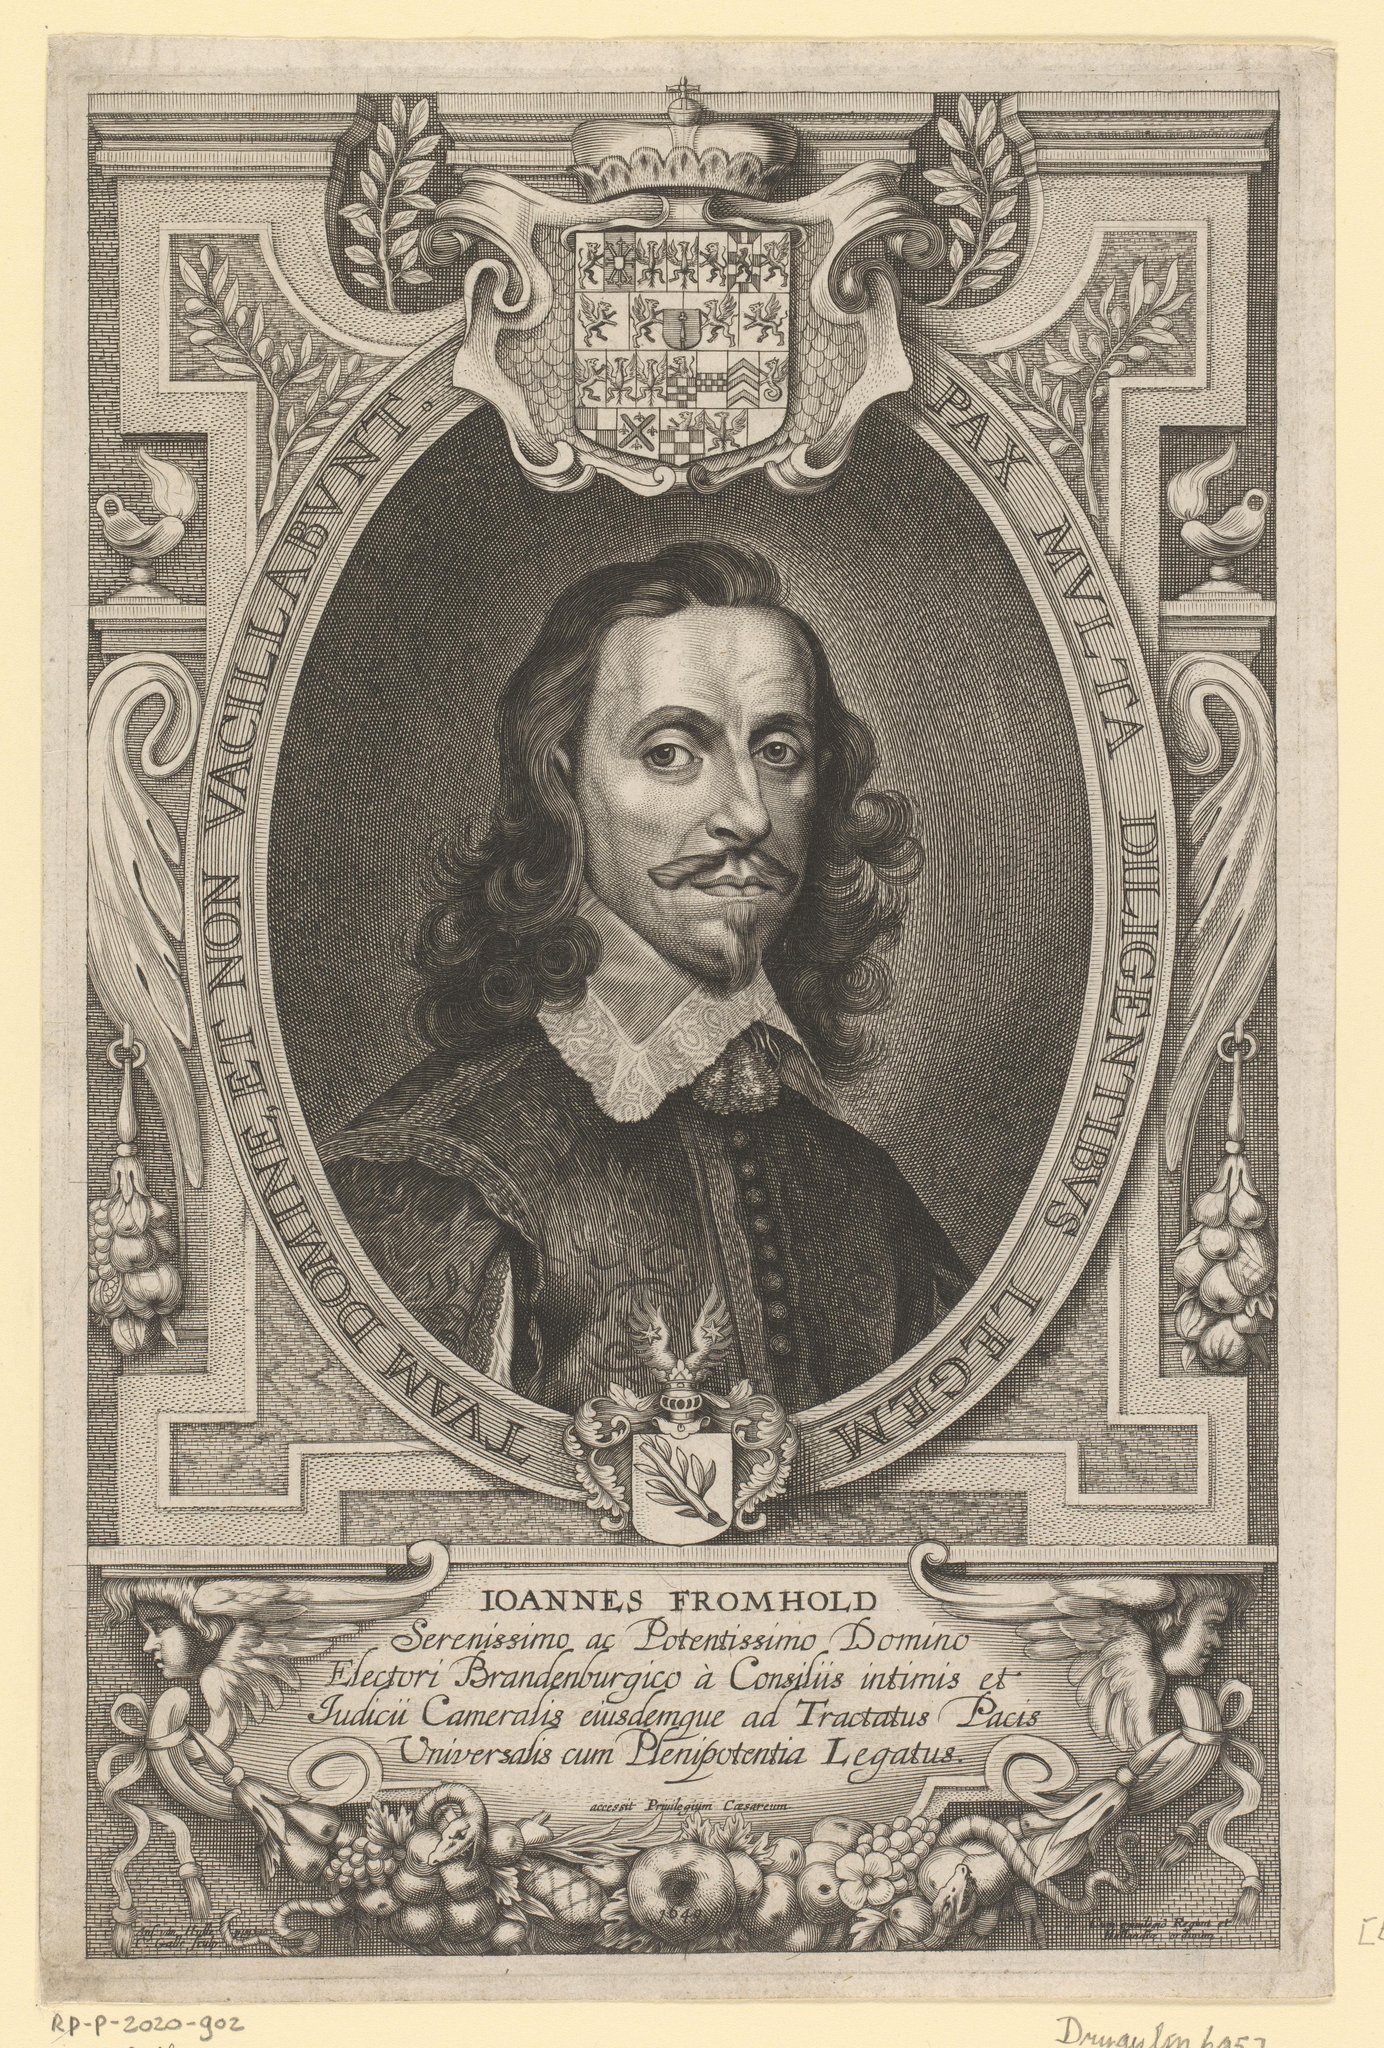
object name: print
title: Portret van Johann Fromhold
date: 1649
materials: paper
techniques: engraving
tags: official; civil servant; functionary (in general), historical persons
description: Prent is gebruikt in verschillende series. De huidige staat is gebruikt in de hieronder vermelde serie en uitgaven (3) en (4) en mogelijk ook in (5) en (6). (1)'Icones legatorum (...)', uitgegeven door Daniel Middeler in 1648 in Antwerpen. (2)‘Legati Celeberrimi’, uitgegeven door Daniel Middeler in 1648 in Antwerpen. (3)‘Legati Celeberrimi’, waarschijnlijk uitgegeven in 1651, maar opnieuw met de vermelding door Daniel Middeler in 1648 in Antwerpen. (4)‘Legati Celeberrimi', waarschijnlijk uitgegeven in 1658, maar opnieuw met de vermelding door Daniel Middeler in 1648 in Antwerpen. (5) 'Pacificatores orbis Christiani, sive icones principum, ducum et legatorum, qui Monasterii atque Osnabrugae (...)', uitgegeven door Pieter van der Slaart in 1696 in Rotterdam. (6) 'Pacificatores orbis Christiani, sive icones principum, ducum et legatorum, qui Monasterii atque Osnabrugae (...)', uitgegeven door Pieter van der Slaart in 1697 in Rotterdam. (7) 'Pacificatores orbis Christiani, sive icones principum, ducum et legatorum, qui Monasterii atque Osnabrugae (...)', waarschijnlijk uitgegeven circa 1713, maar opnieuw met vermelding van Pieter van der Slaart in 1697 in Rotterdam. De platen in deze uitgave zijn voor het eerst genummerd. (8) 'Les hommes illustres qui ont vécu dans le XXIIe siècle (...)', uitgegeven door David Mortier in 1717 in Rotterdam. Zie documentatie. Mogelijk zijn er nog meerdere uitgaven en staten van deze prent.